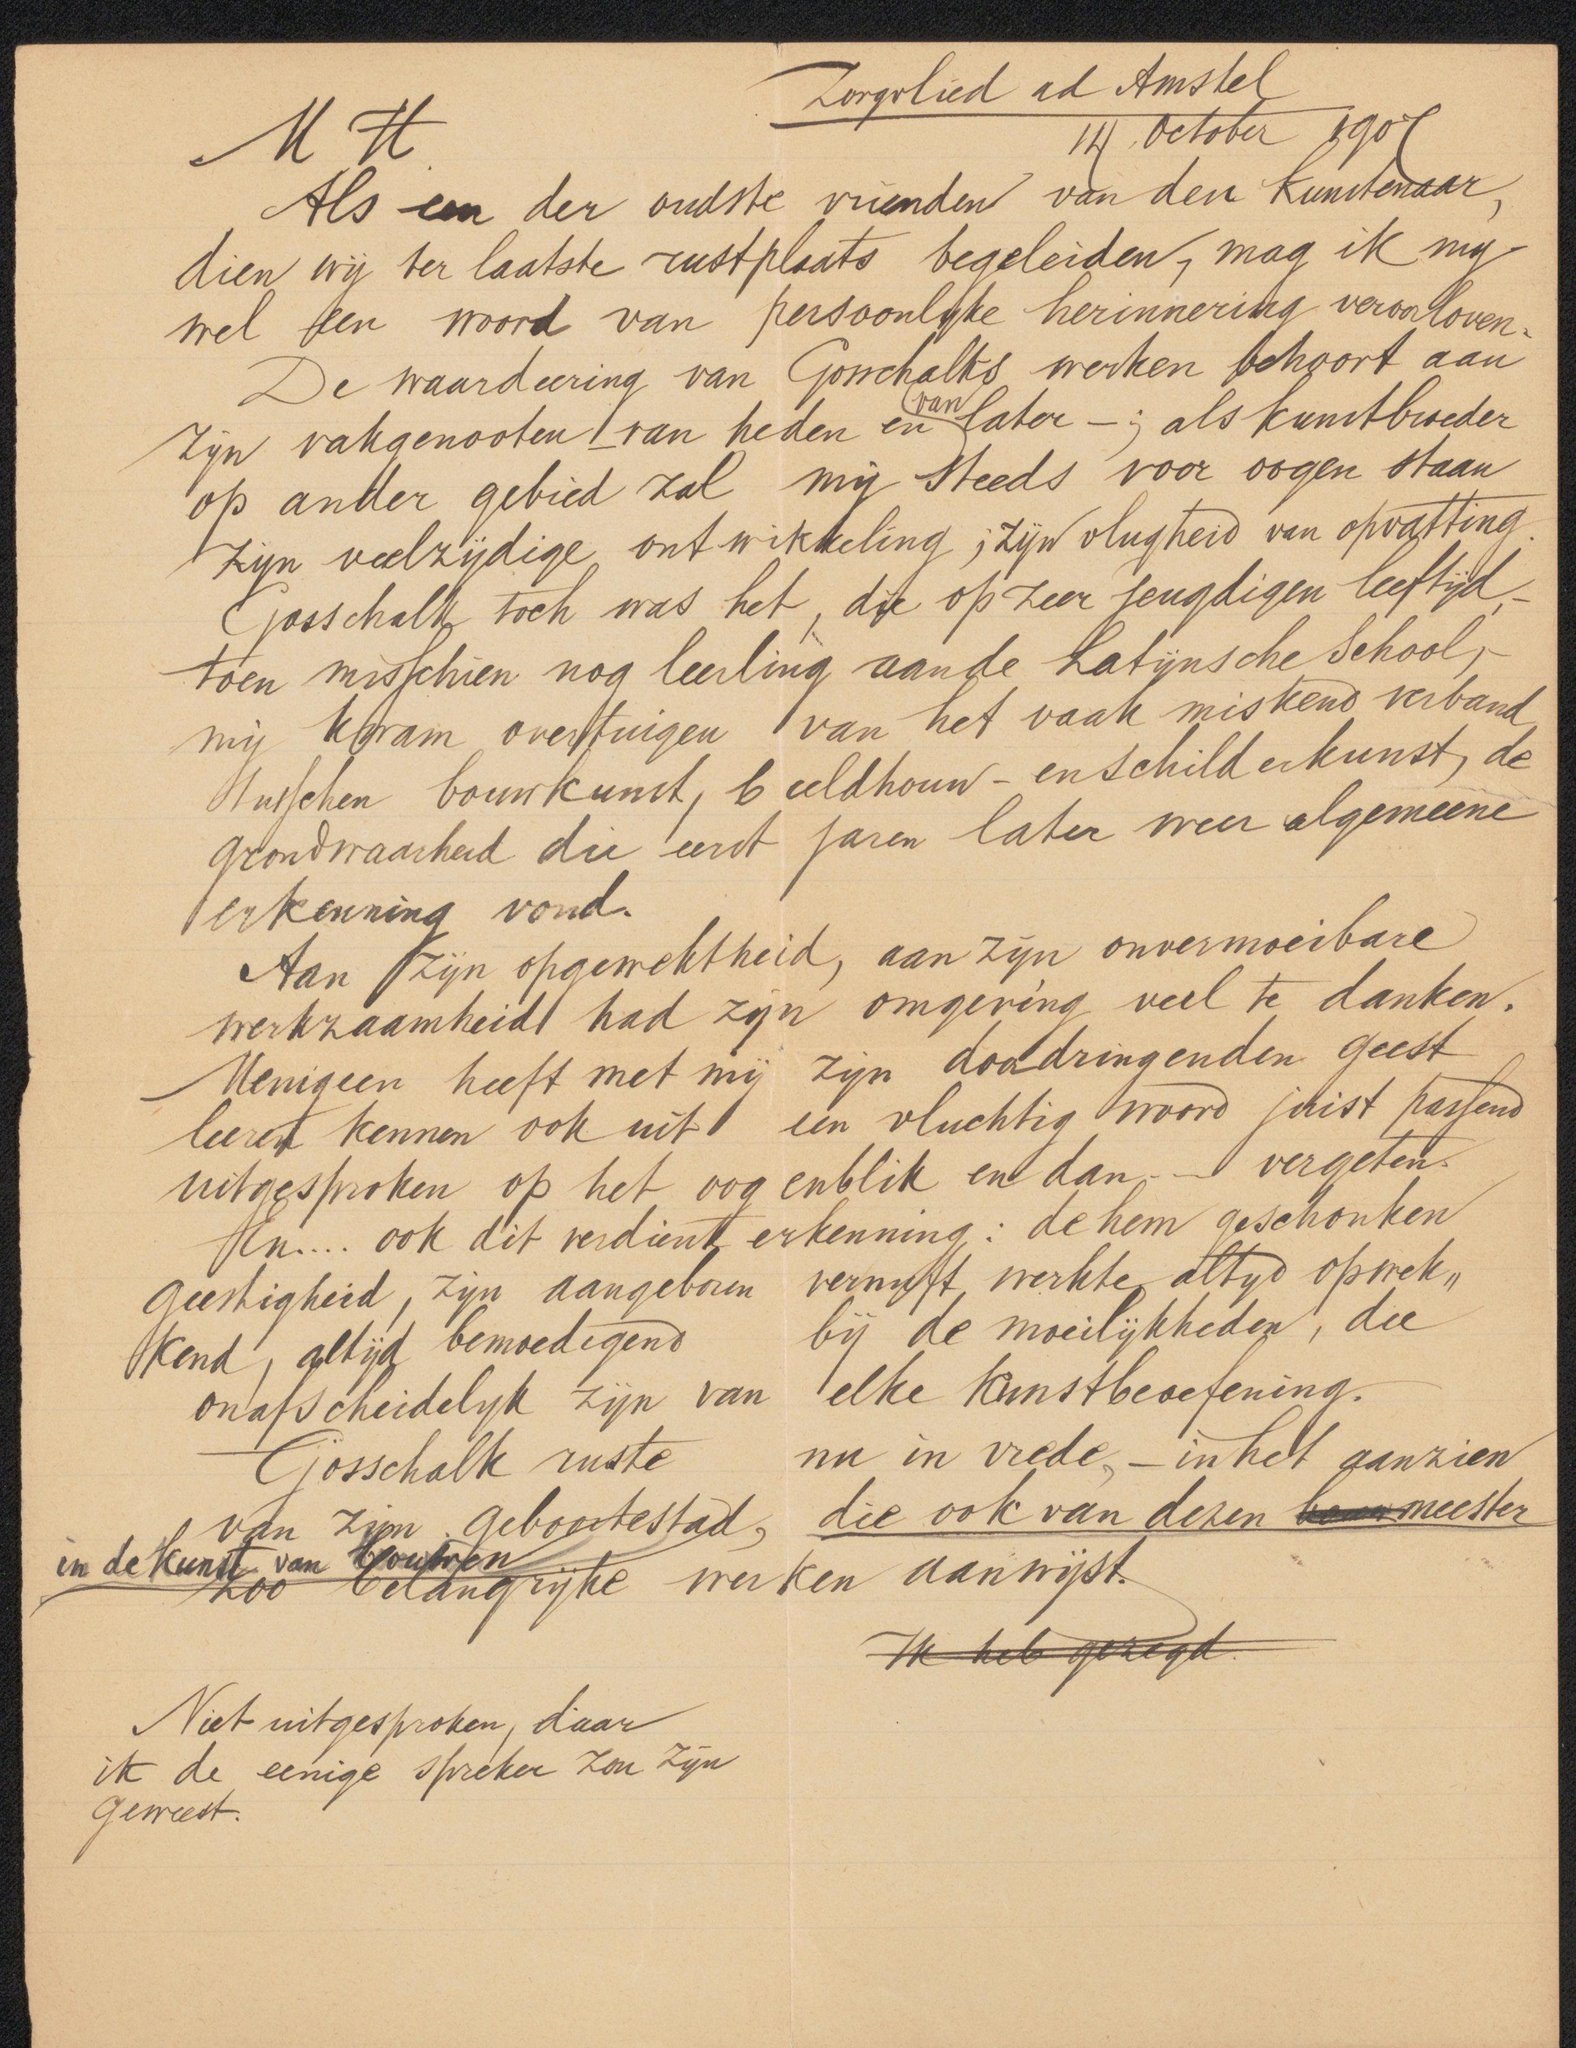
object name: tekst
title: Rede bij de begrafenis van Isaac Gosschalk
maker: august allebé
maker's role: draughtsman, print maker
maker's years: 1838-1927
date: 1907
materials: ink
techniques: pen, writing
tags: brussels, isaac gosschalk